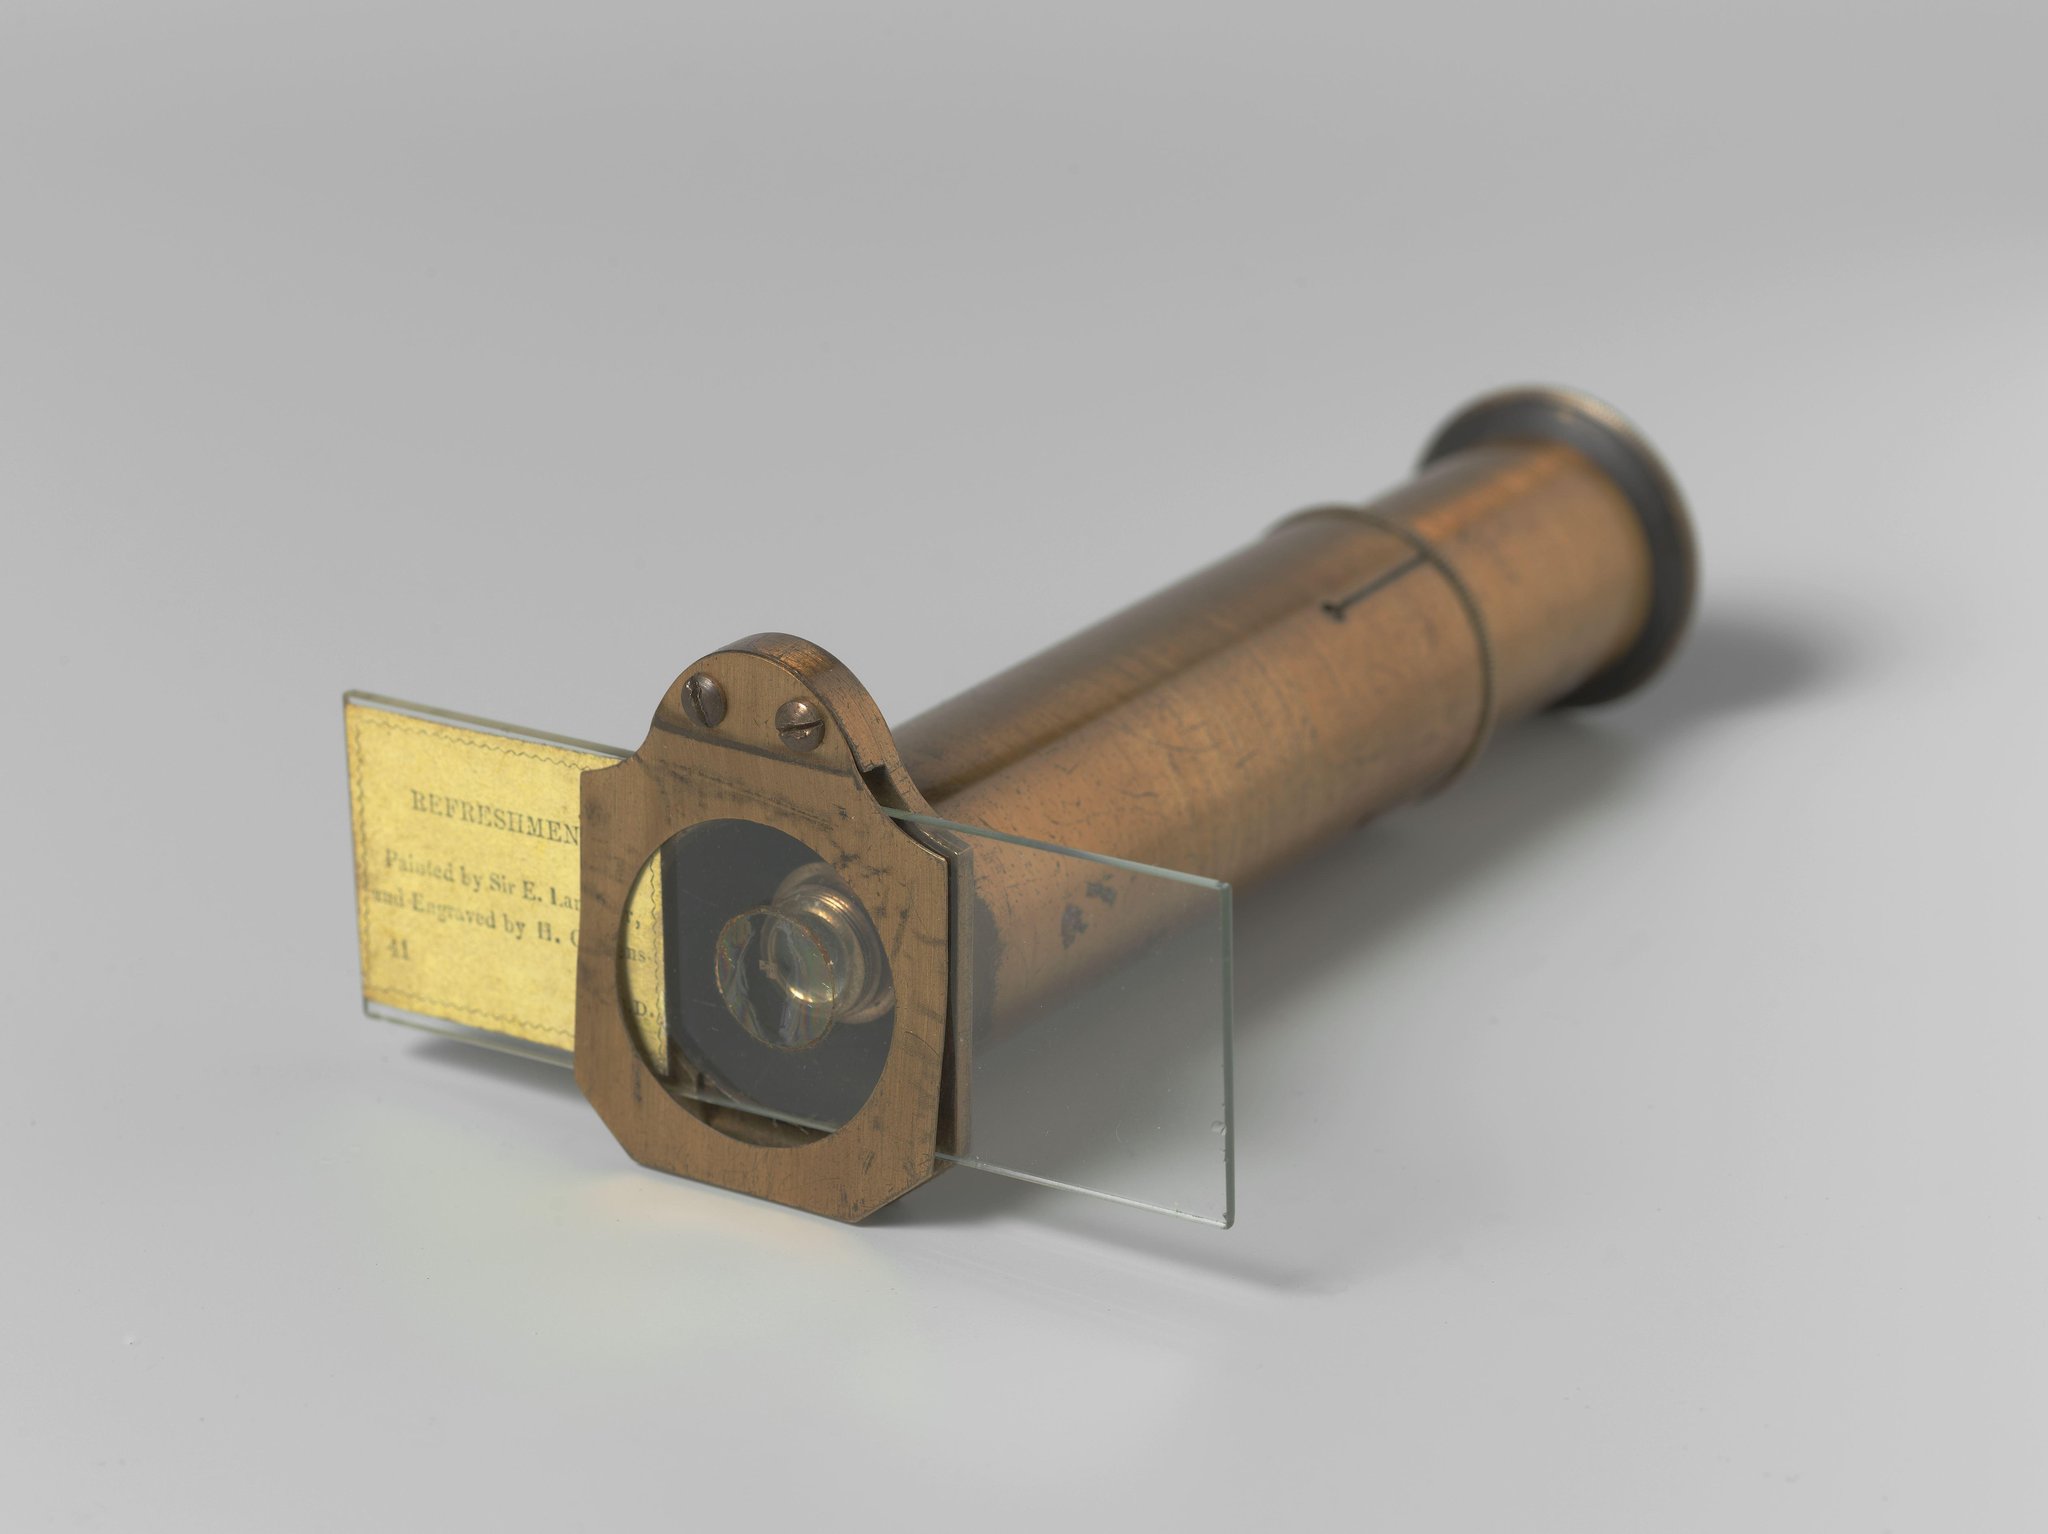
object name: dutch viewer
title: Microscoop voor microfoto's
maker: Anonymous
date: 1851-1887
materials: brass, glass